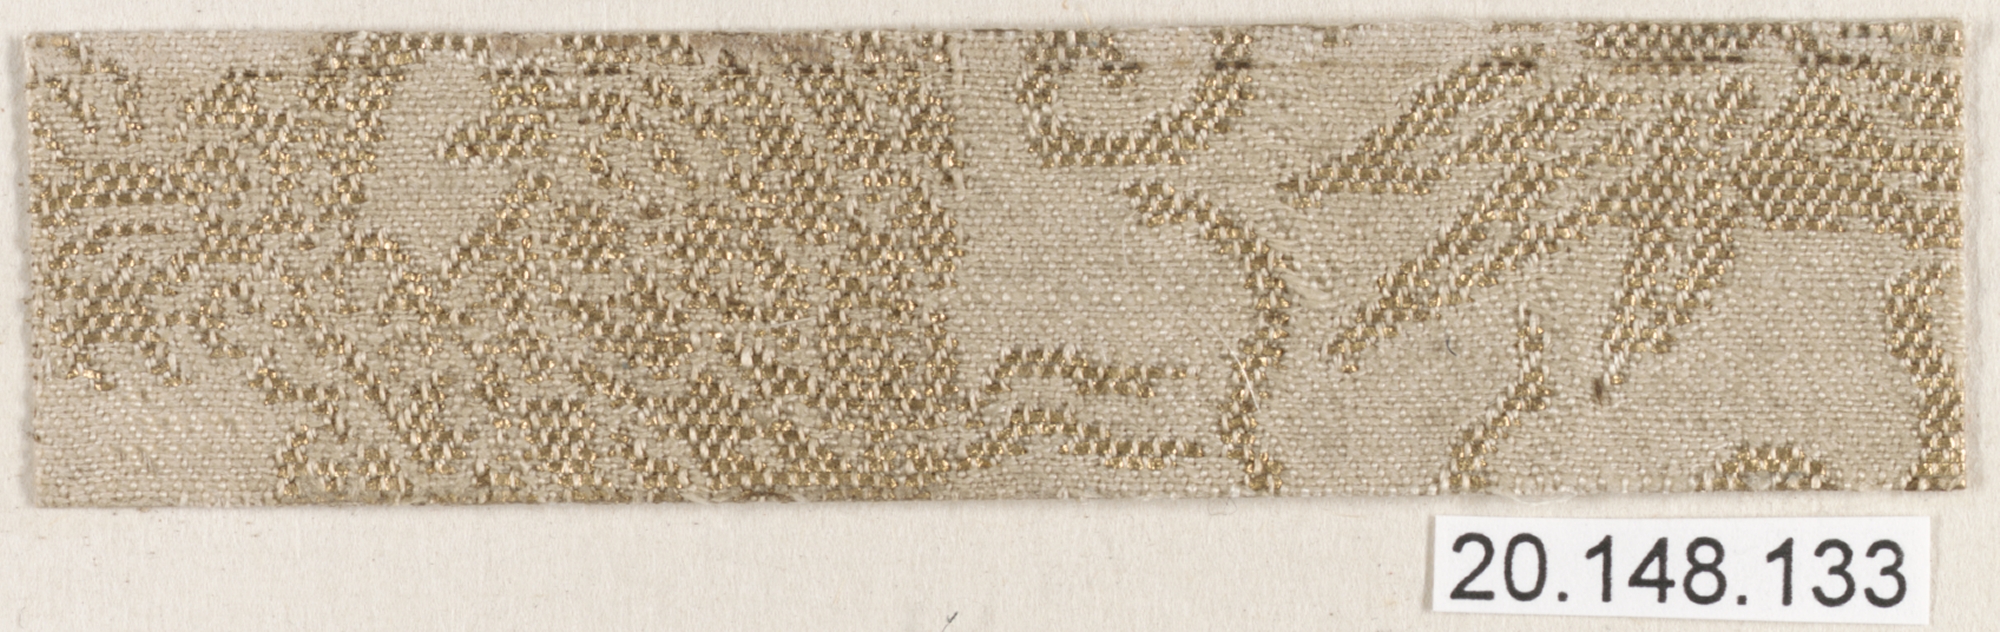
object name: piece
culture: japanese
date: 1501-1600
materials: silk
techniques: compound weave